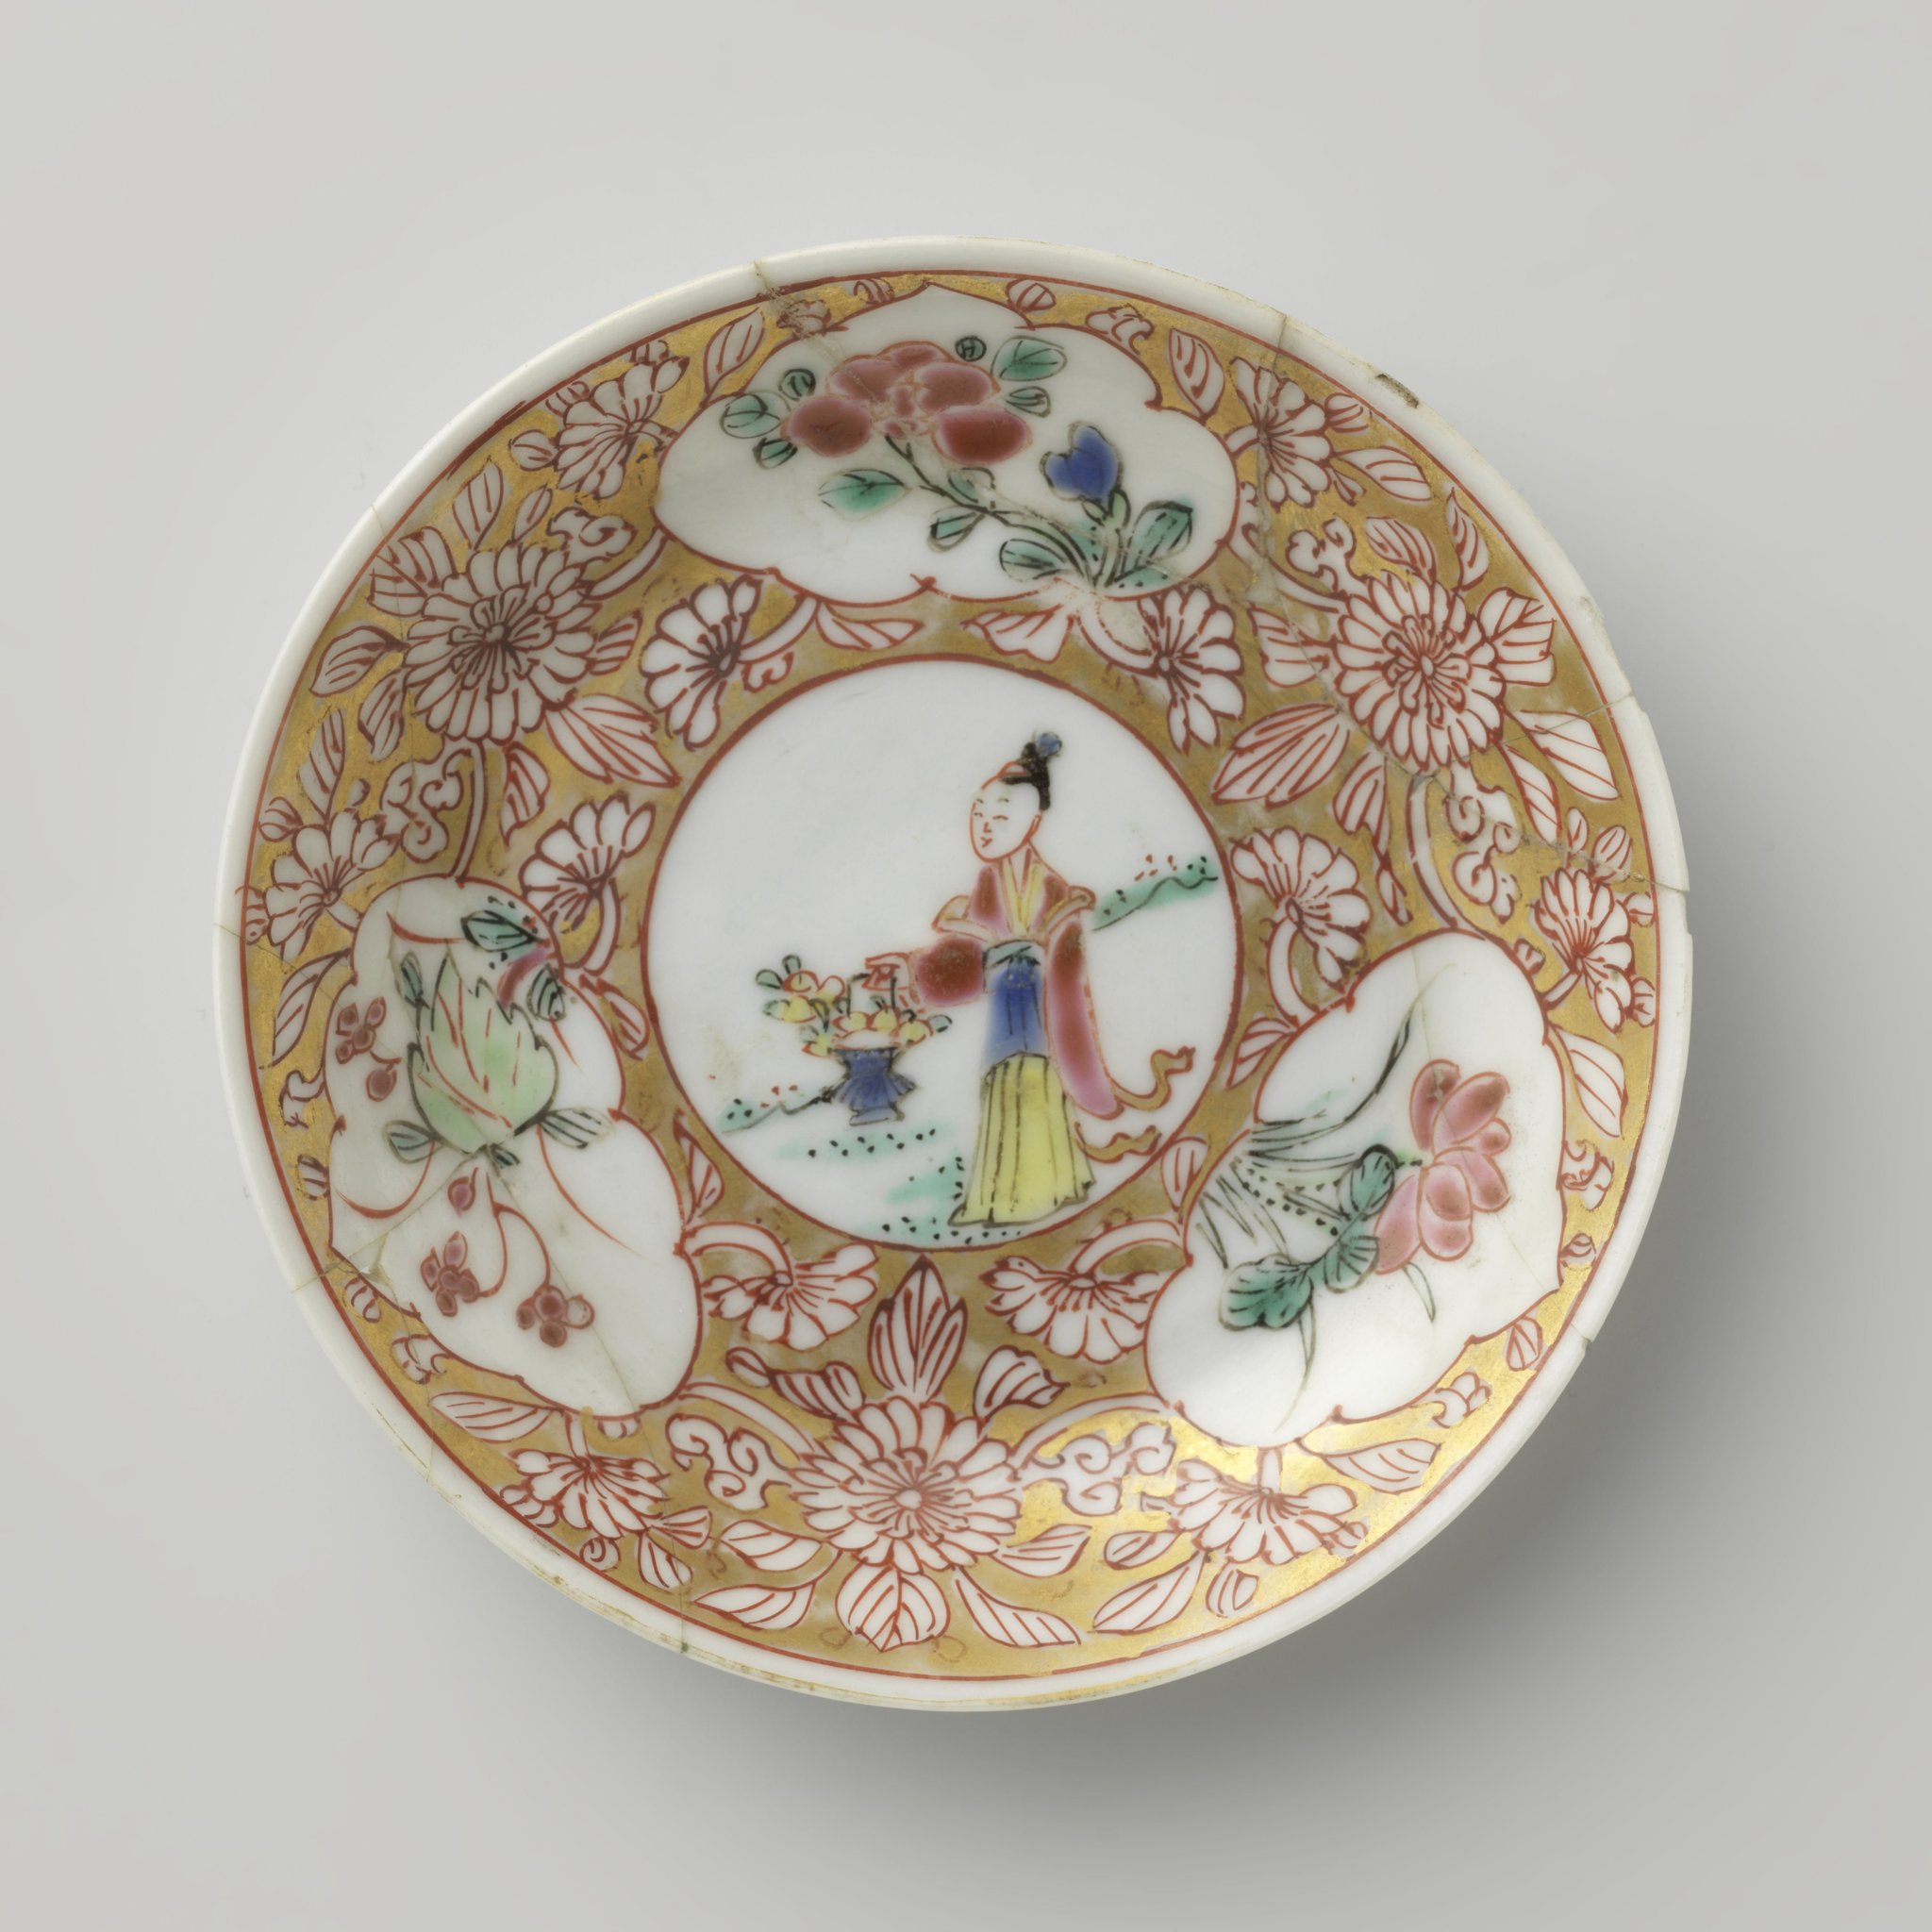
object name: platter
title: Saucer with a woman with flower basket and flowering plants in panels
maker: Anonymous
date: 1725-1749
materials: glaze, gold, paint, porcelain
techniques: firing, gilding, turning, vitrification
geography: china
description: Schotel van porselein met spreidende wand, beschilderd op het glazuur in blauw, rood, roze, groen, zwart en goud. Op het plat van de schotel een medaillon met een vrouw in een landschap met een bloemenmand; om het medaillon uitgespaarde bloemranken en drie cartouches met bloeiende planten (o.a. lotus) in een gouden grond. Schotel is gebroken geweest. Famille rose.